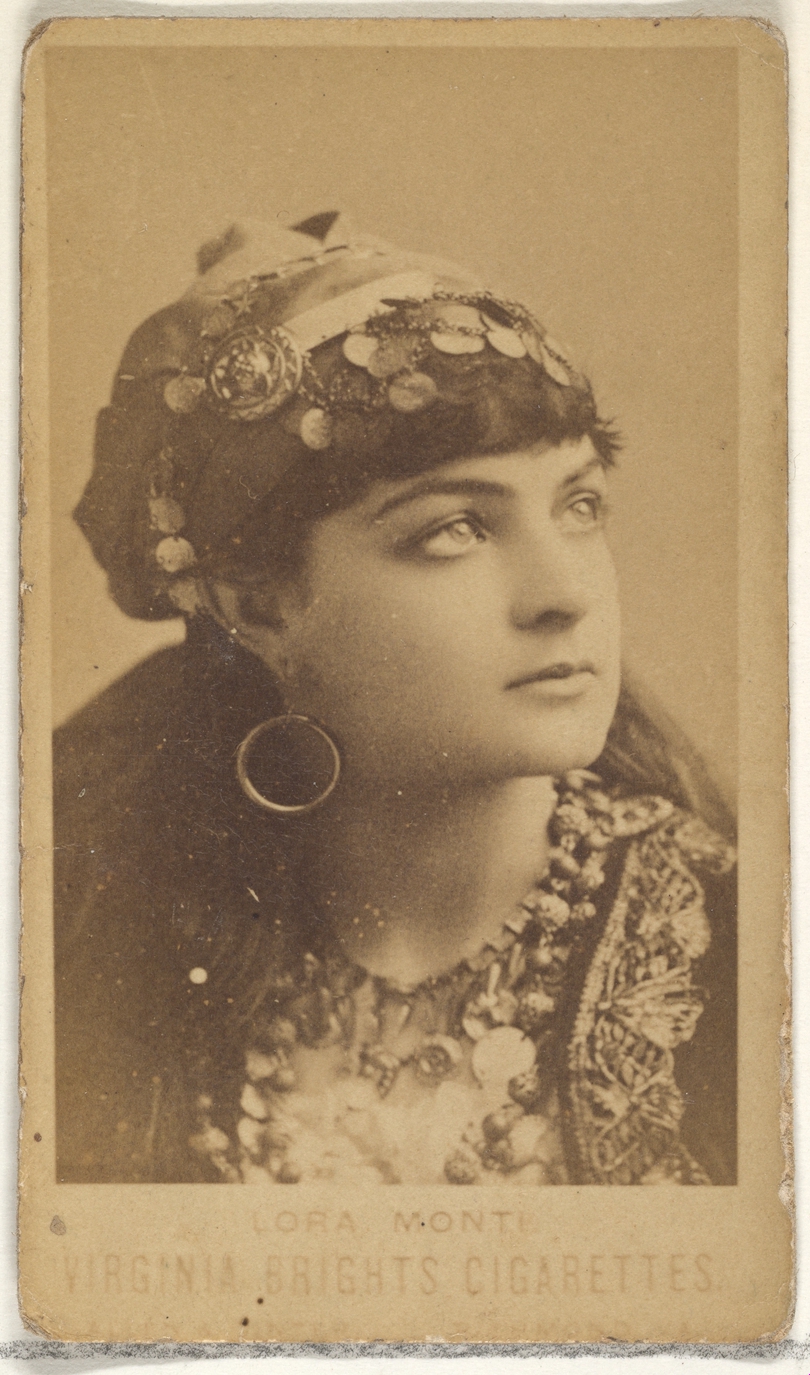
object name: photograph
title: Lora Monti, from the Actors and Actresses series (N45, Type 1) for Virginia Brights Cigarettes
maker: allen & ginter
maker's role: publisher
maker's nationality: american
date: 1888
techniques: albumen silver print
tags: portraits,women,actresses